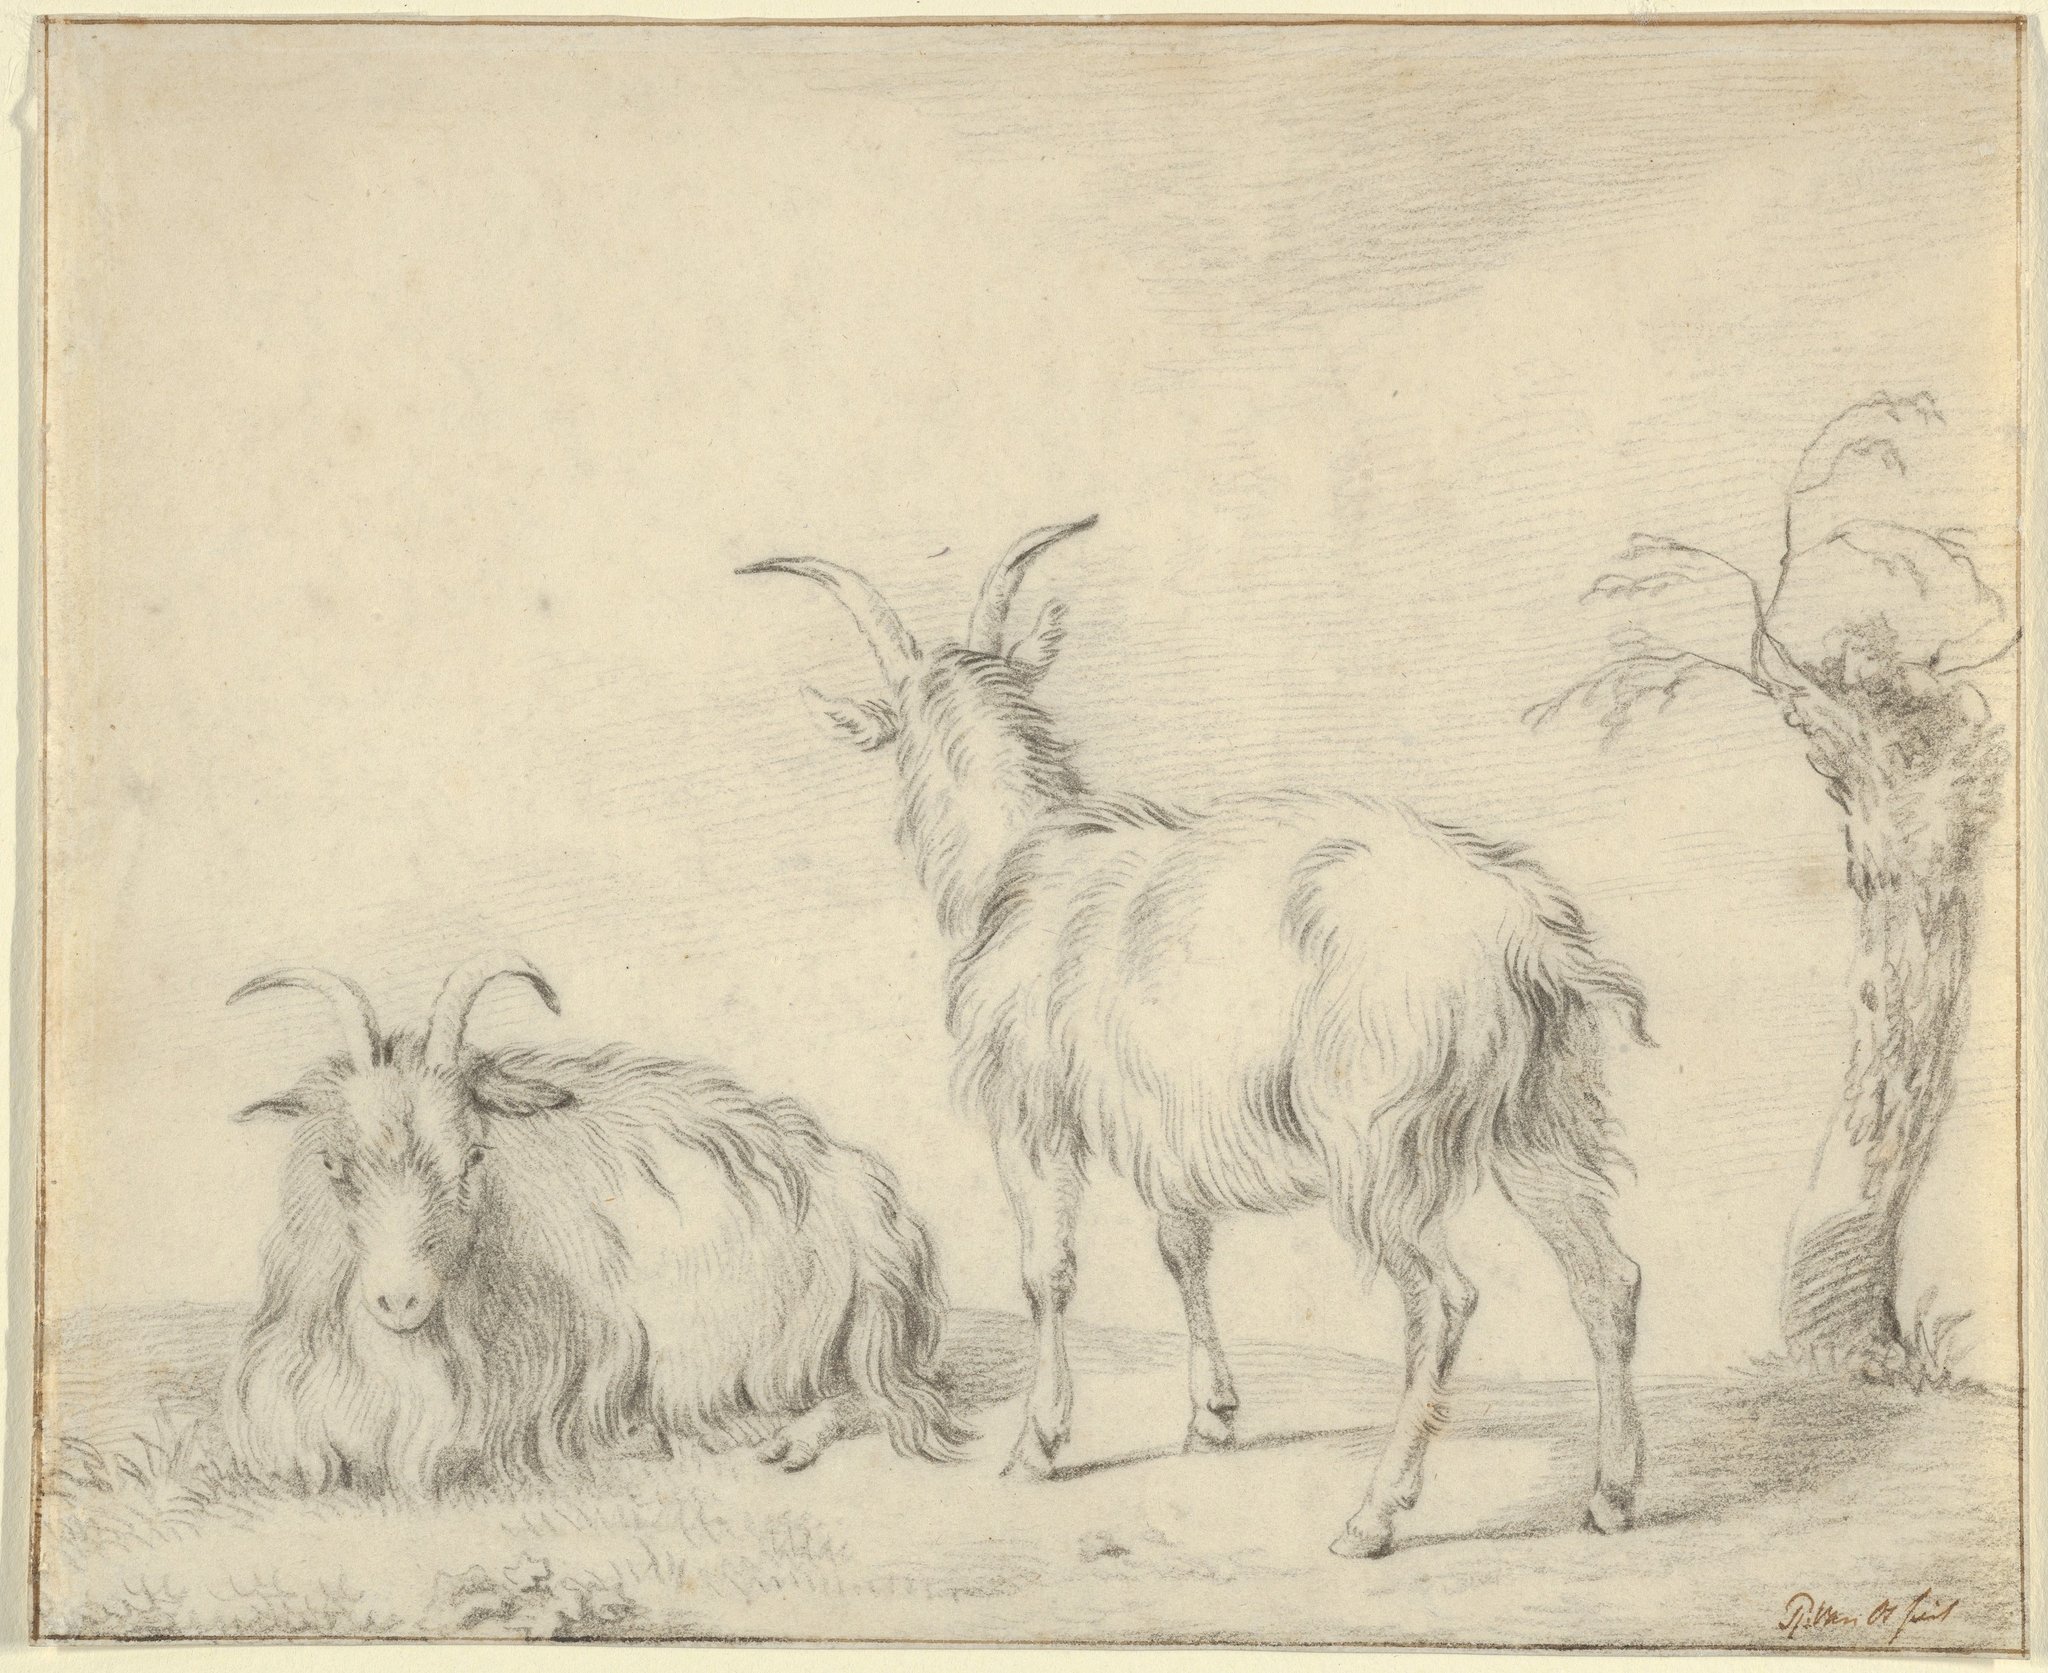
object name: drawing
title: A Standing and a Lying Goat Near a Small Tree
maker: pieter gerardus van os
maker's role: artist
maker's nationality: dutch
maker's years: 1776-1836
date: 1801-1833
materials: chalk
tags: goats,trees